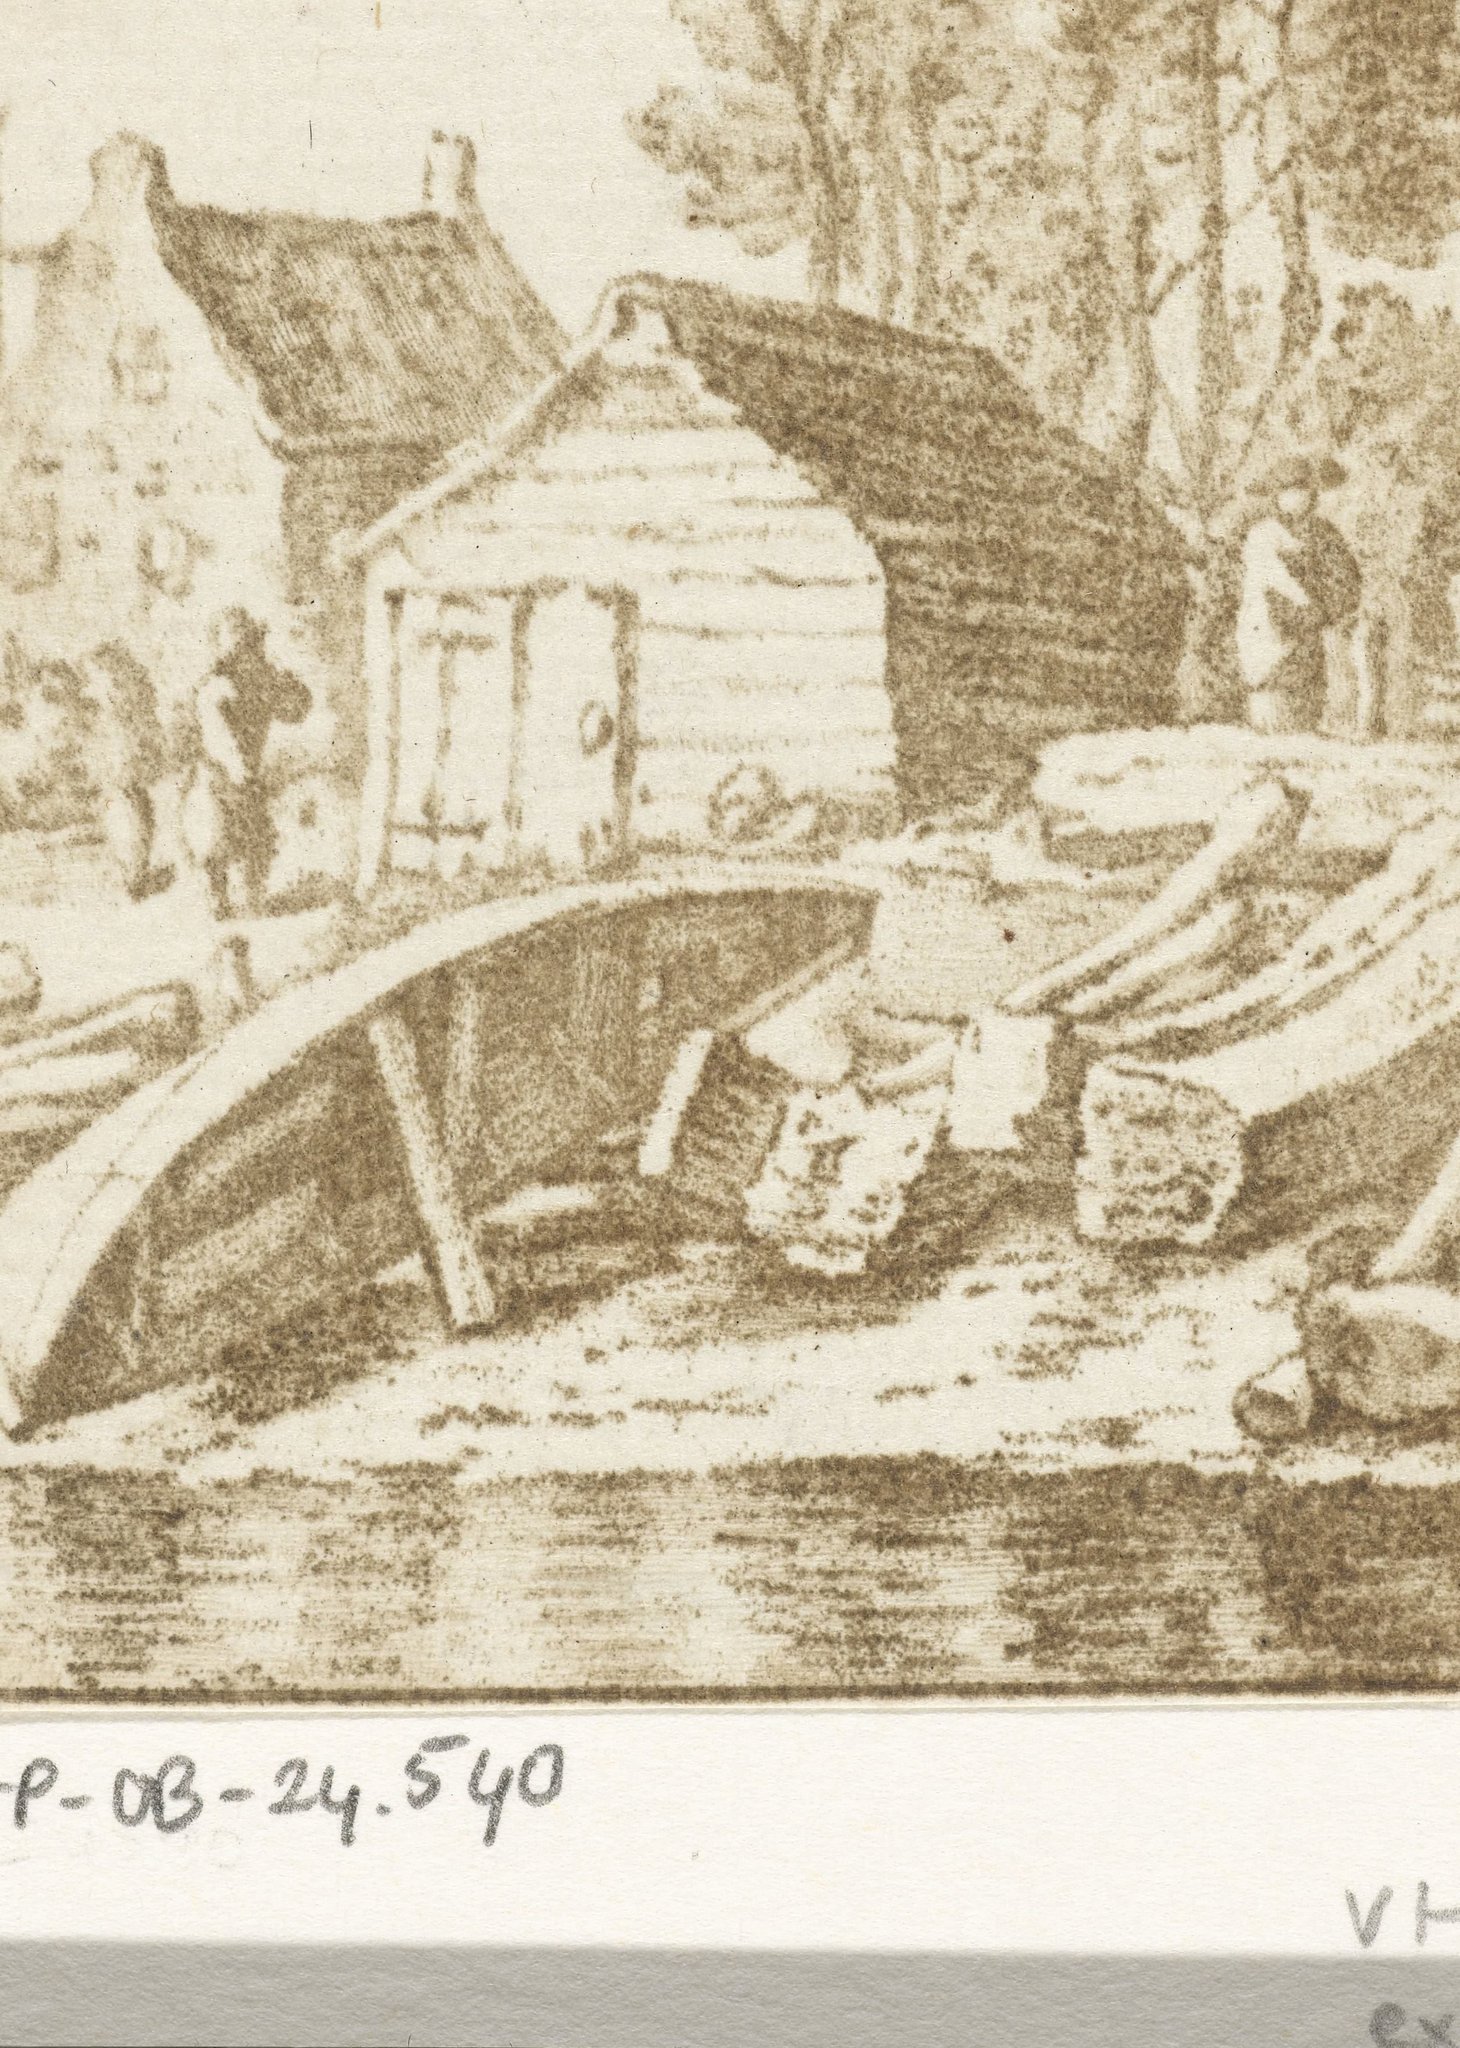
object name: print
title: Prentwerk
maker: cornelis ploos van amstel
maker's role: draughtsman, print maker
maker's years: 1726-1798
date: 1761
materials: paper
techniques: printmaking, etching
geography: amsterdam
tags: shipyard, shipdock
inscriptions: collector's mark: Lugt 240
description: Een scheepswerf met enkele figuren, een huis en een schuur.